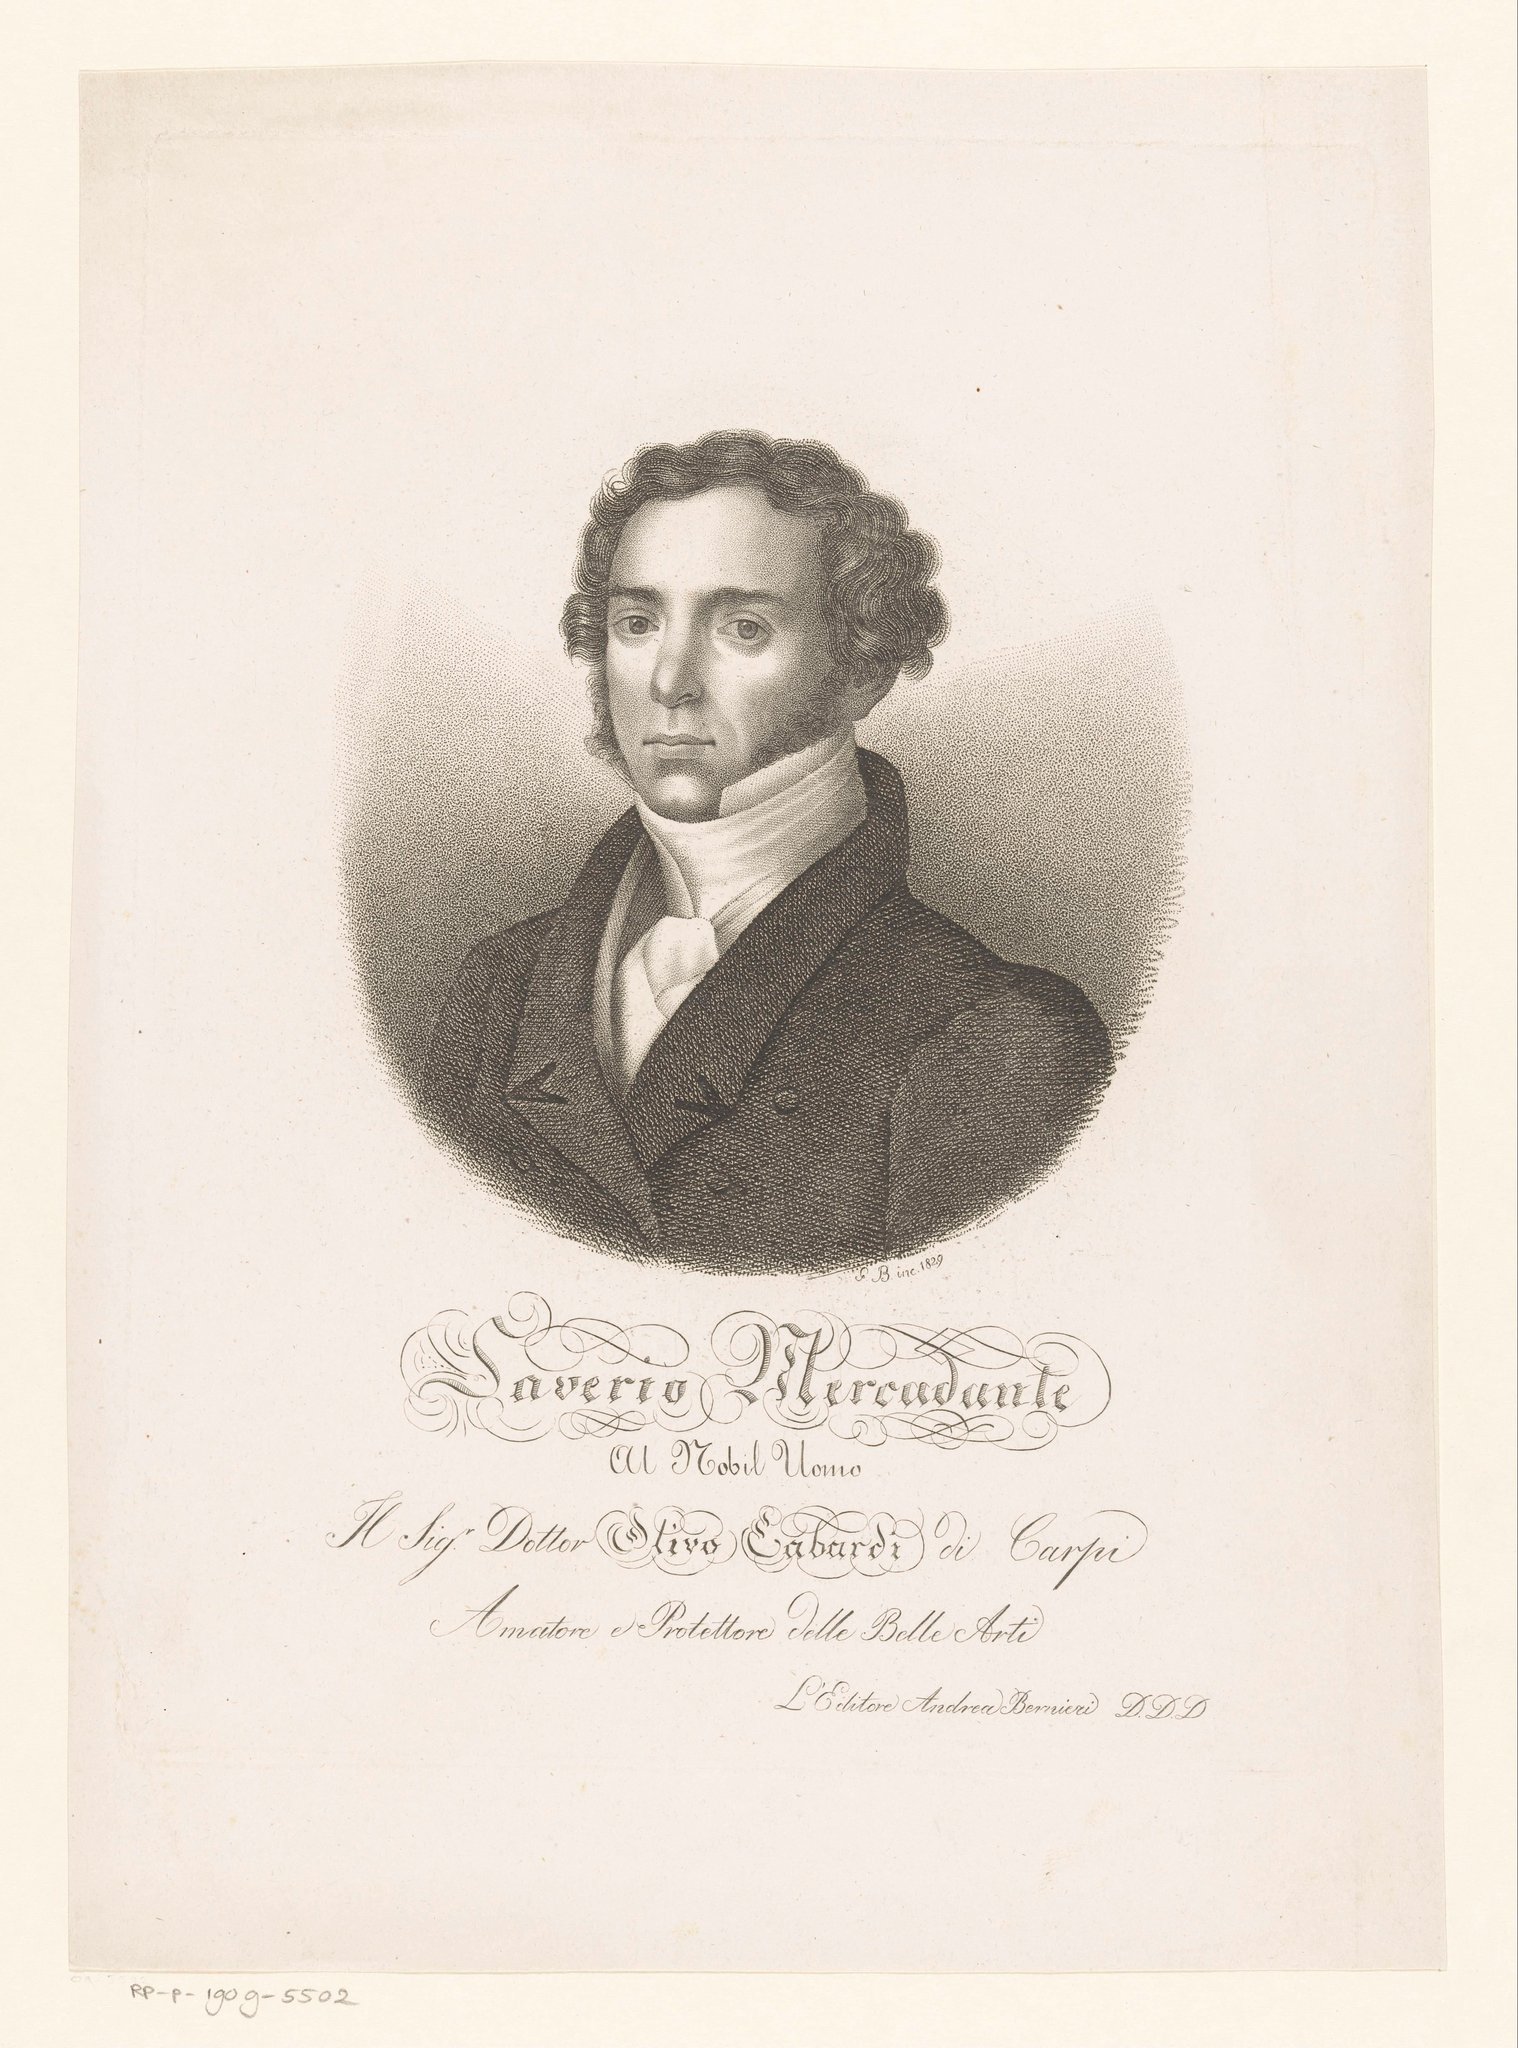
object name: print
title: Portret van componist Saverio Mercadante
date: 1829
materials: paper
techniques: engraving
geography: italy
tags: altamura, naples, historical persons, portrait of composer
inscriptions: collector's mark: Lugt 2228